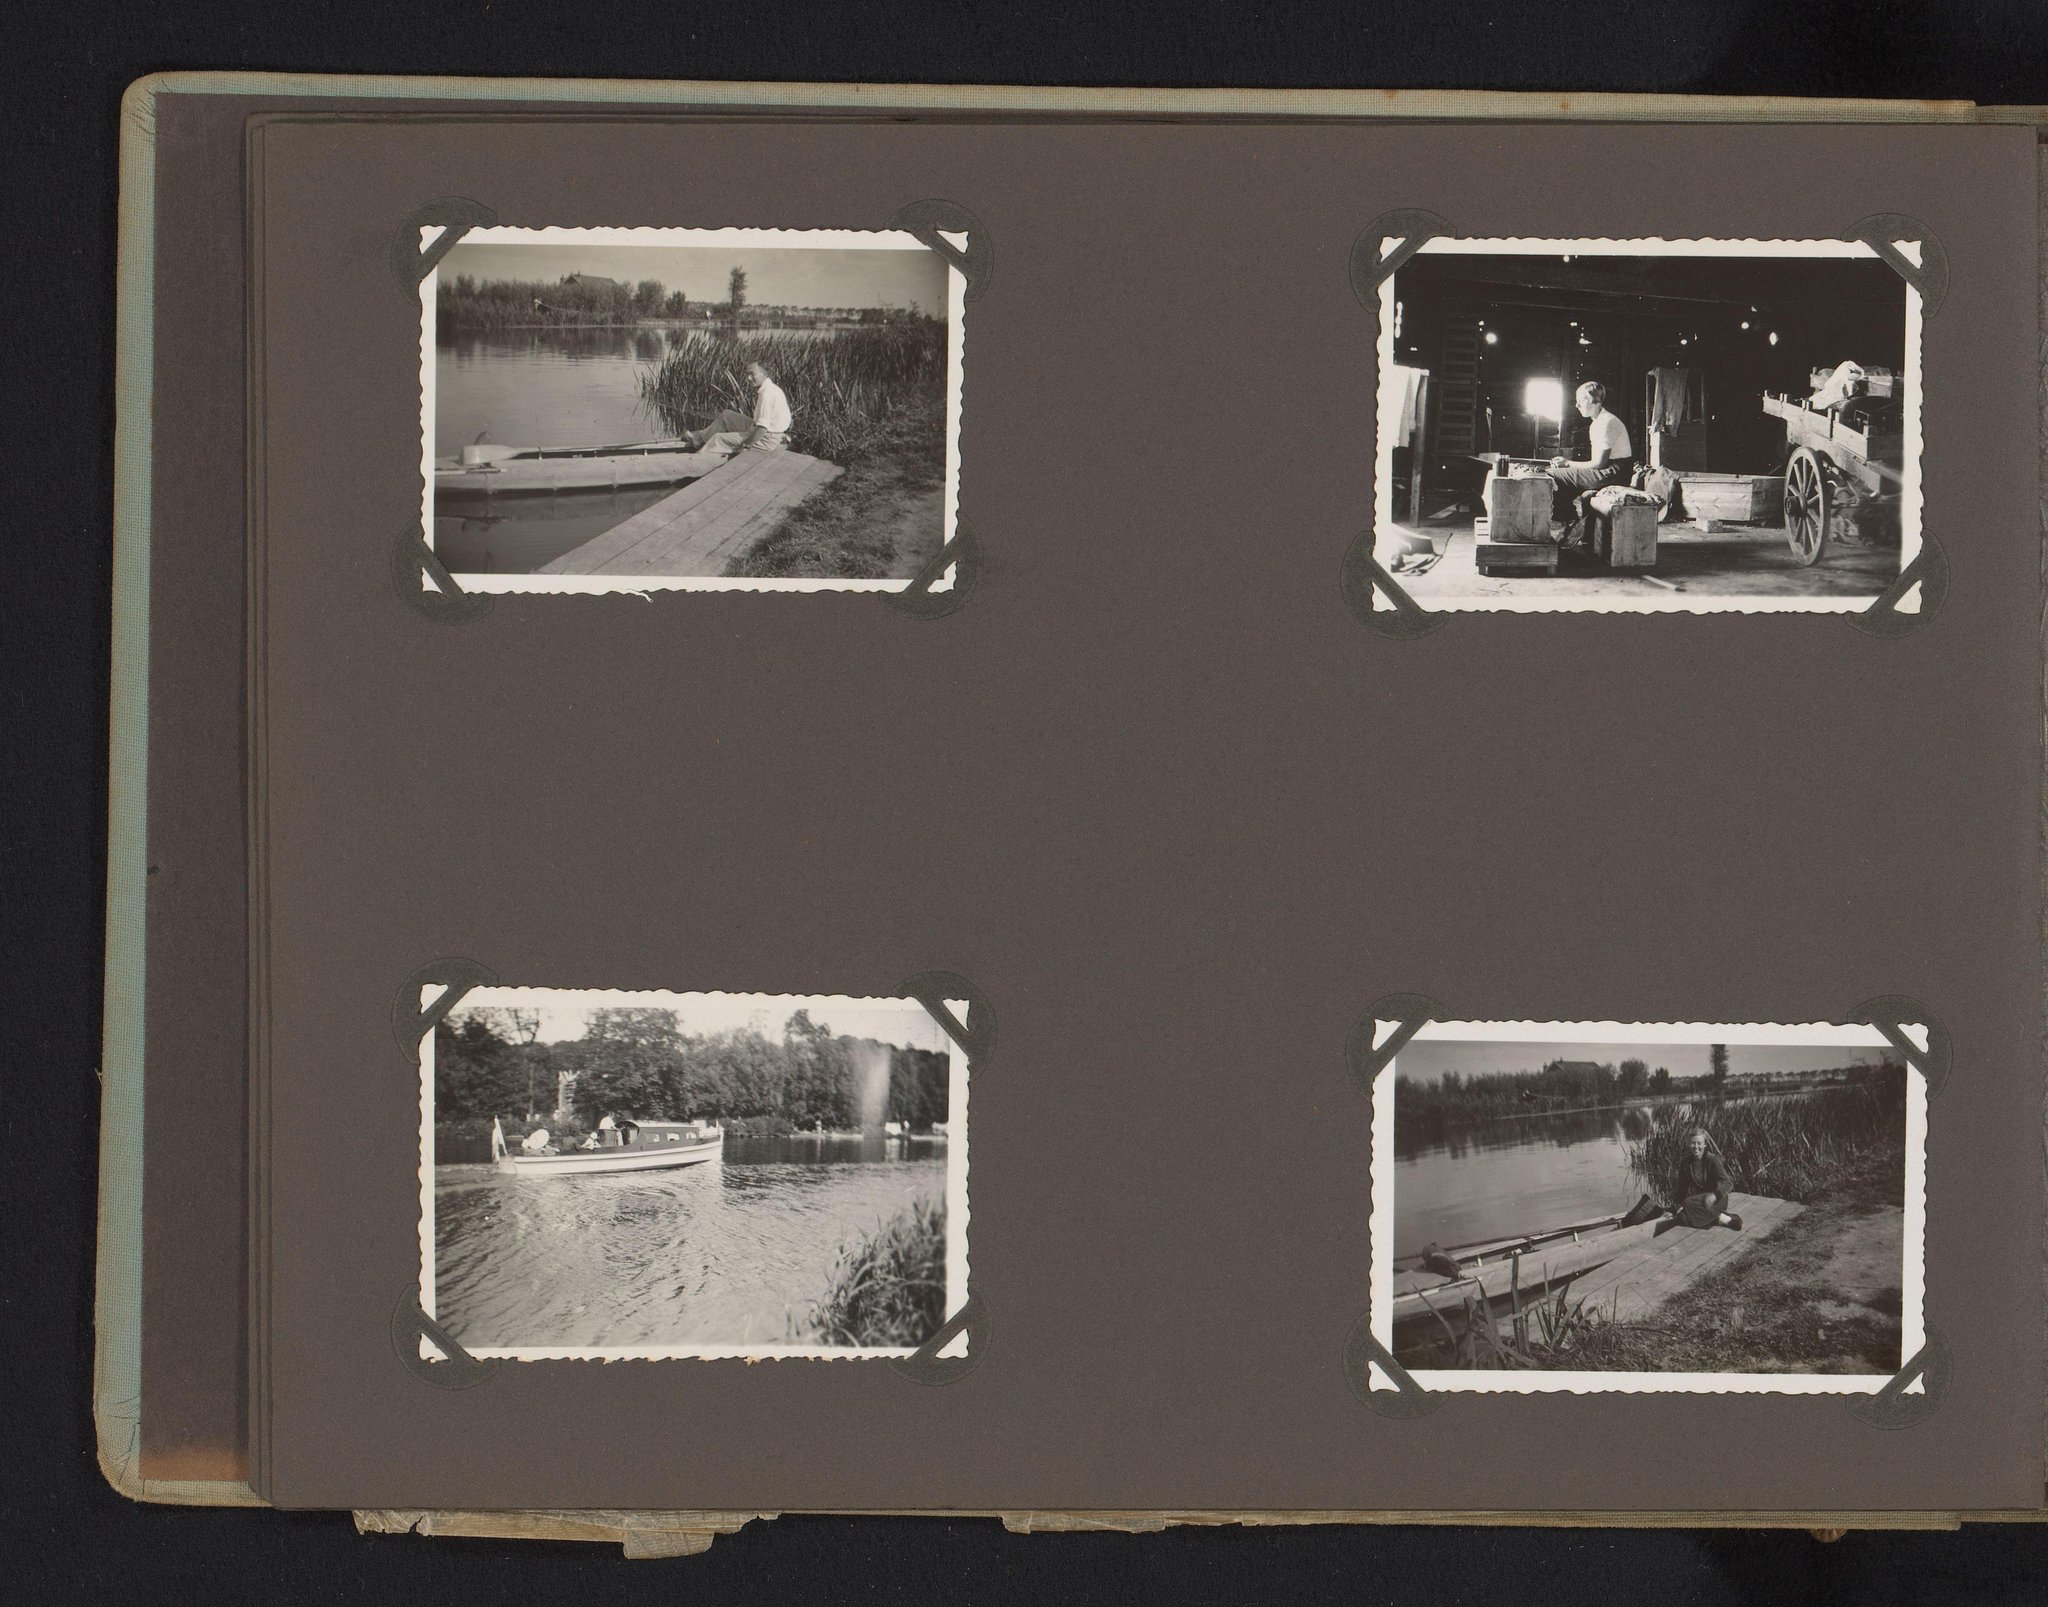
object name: album leaf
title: Varen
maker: Anonymous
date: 1935-1945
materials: cardboard, photographic support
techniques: gelatin silver print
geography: netherlands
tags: rowing-boat, canoe, etc., open-air recreation, netherlands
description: Albumblad met vier foto's van een boottochtje met een vriend. Onderdeel van het fotoalbum van een jonge vrouw, ca. 1935-1945.